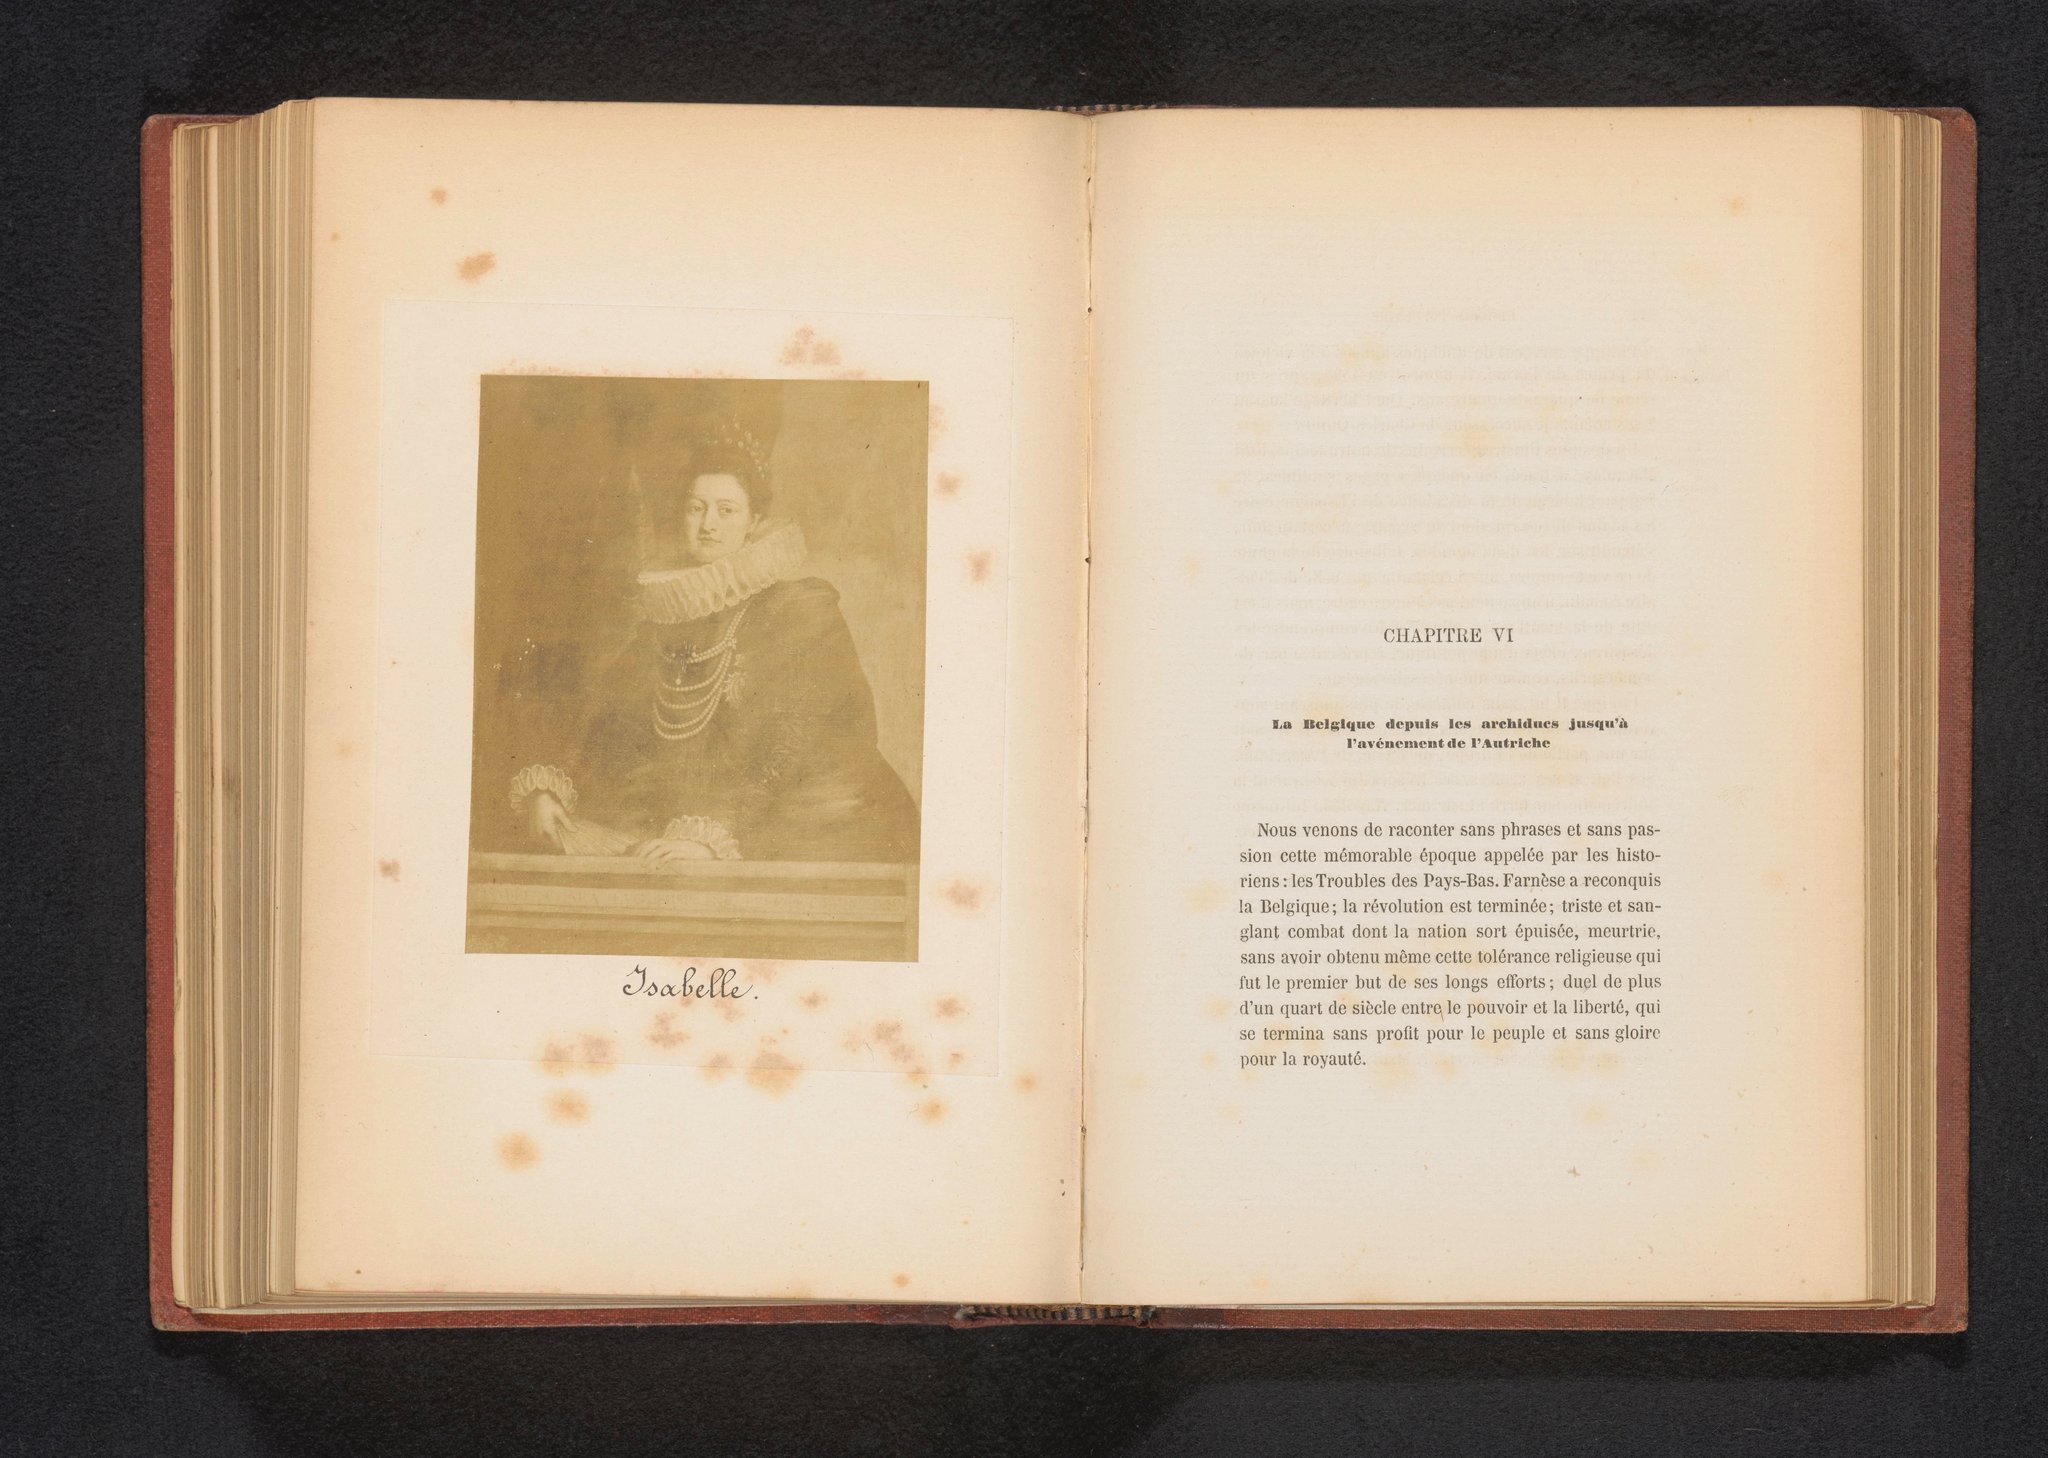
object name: page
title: Isabelle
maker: joseph maes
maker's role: fotograaf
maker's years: 1838-1908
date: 1855-1860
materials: photographic support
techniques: albumen print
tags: infante van spanje isabella clara eugenia, historical persons - bb - woman